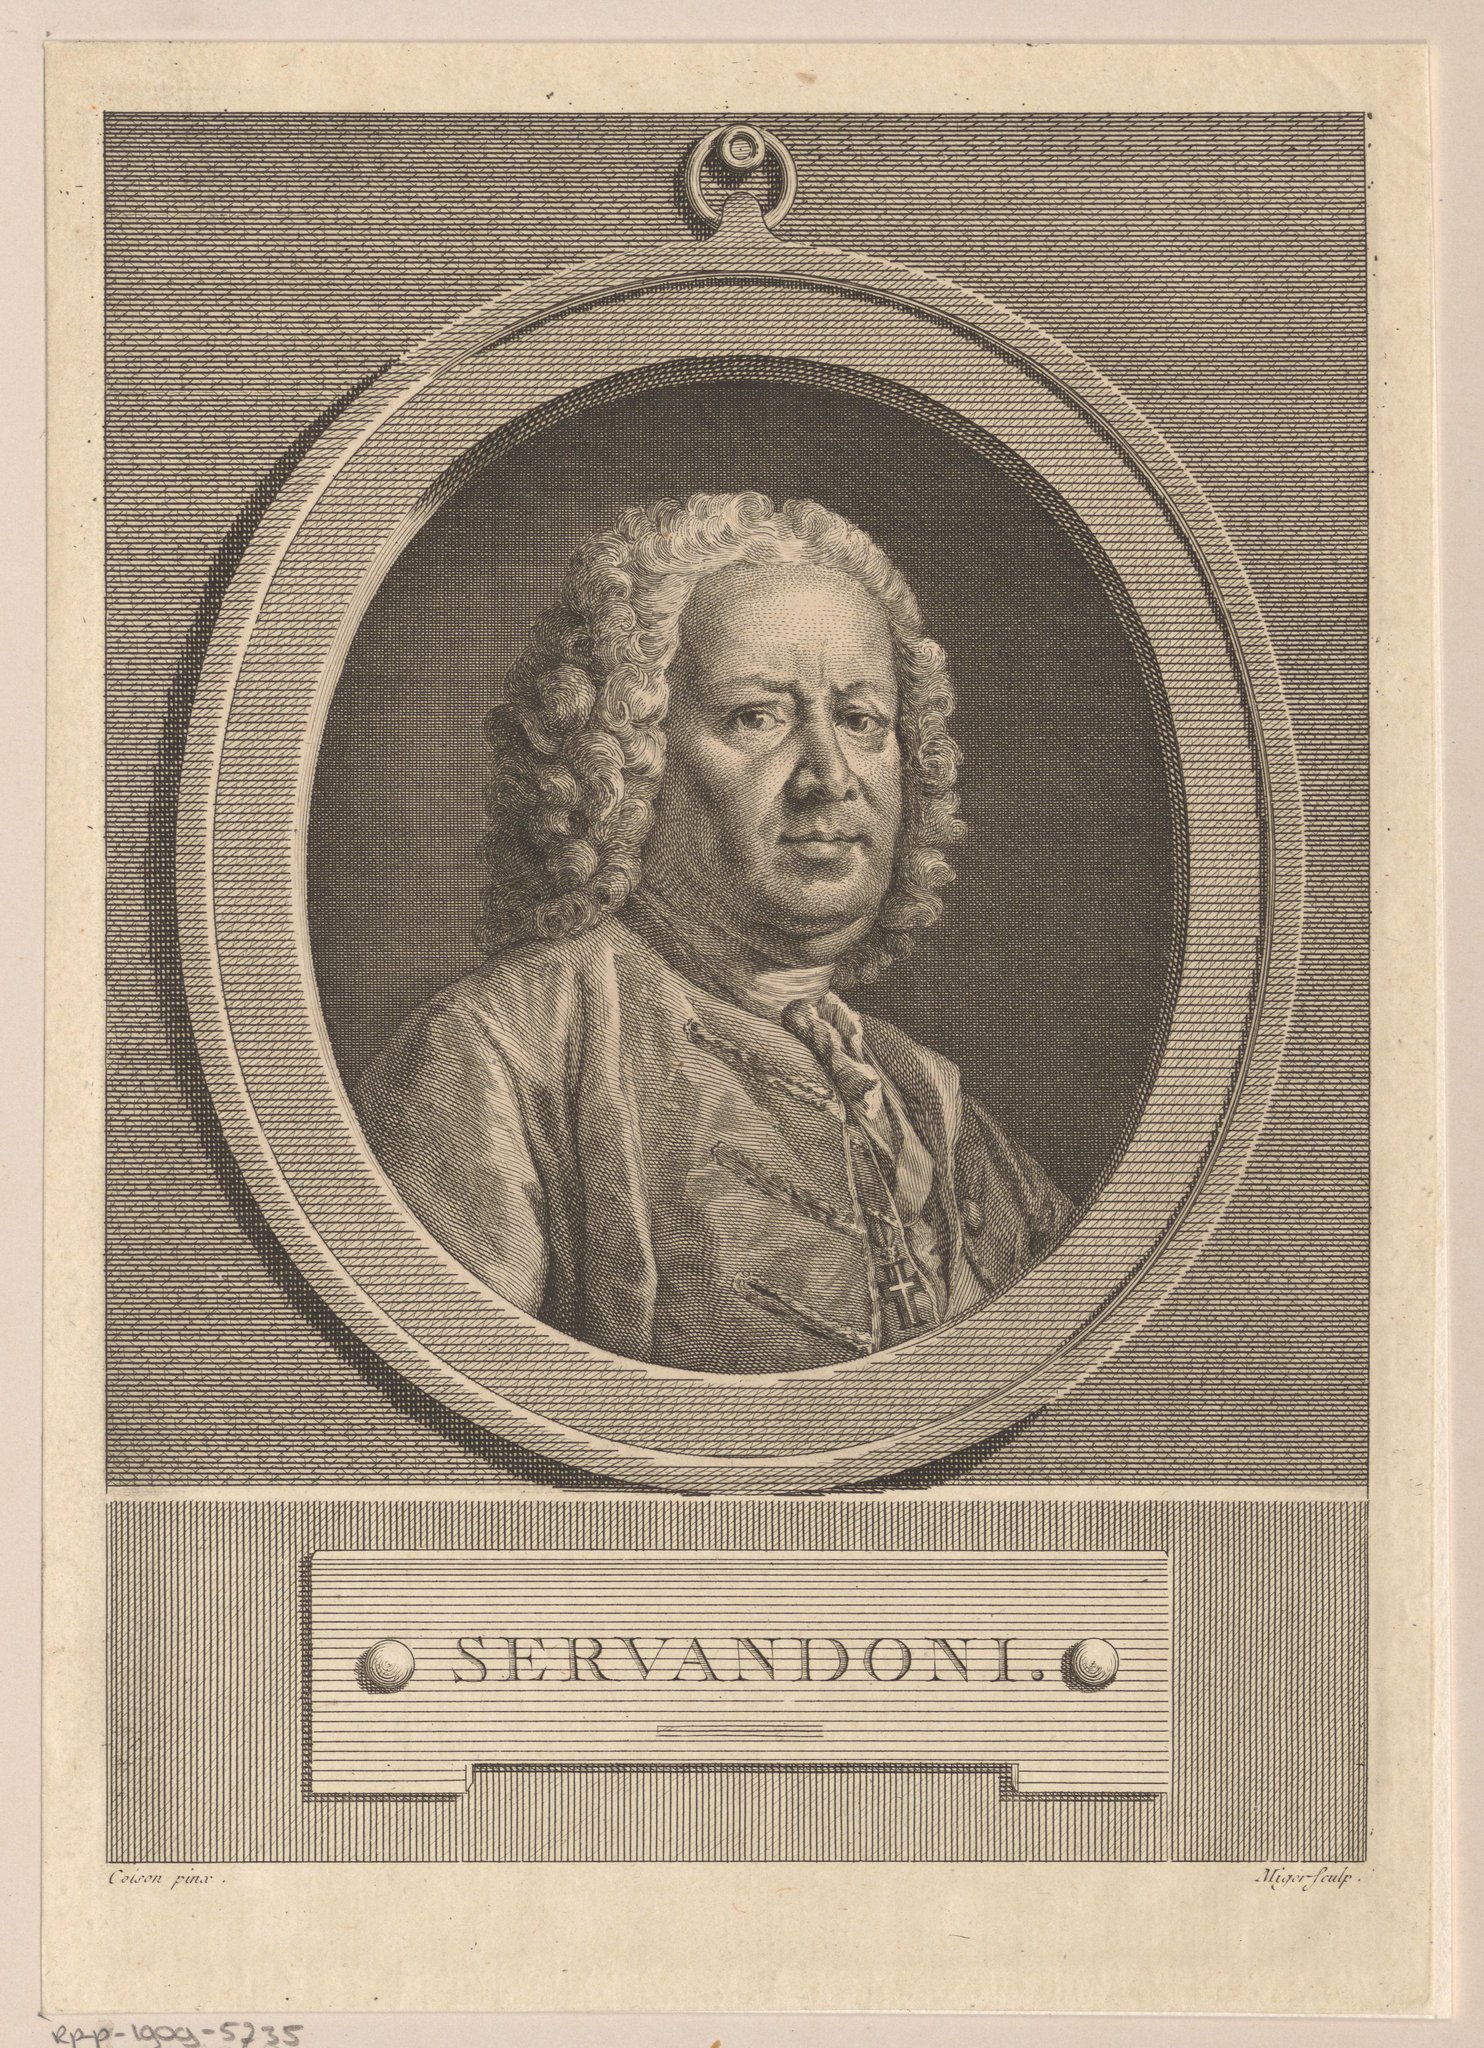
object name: print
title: Portret van Giovanni Niccolò Servandoni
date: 1746-1820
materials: paper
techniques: engraving, etching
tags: painter, designer, historical persons, portrait, self-portrait of artist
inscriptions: collector's mark: Lugt 2228